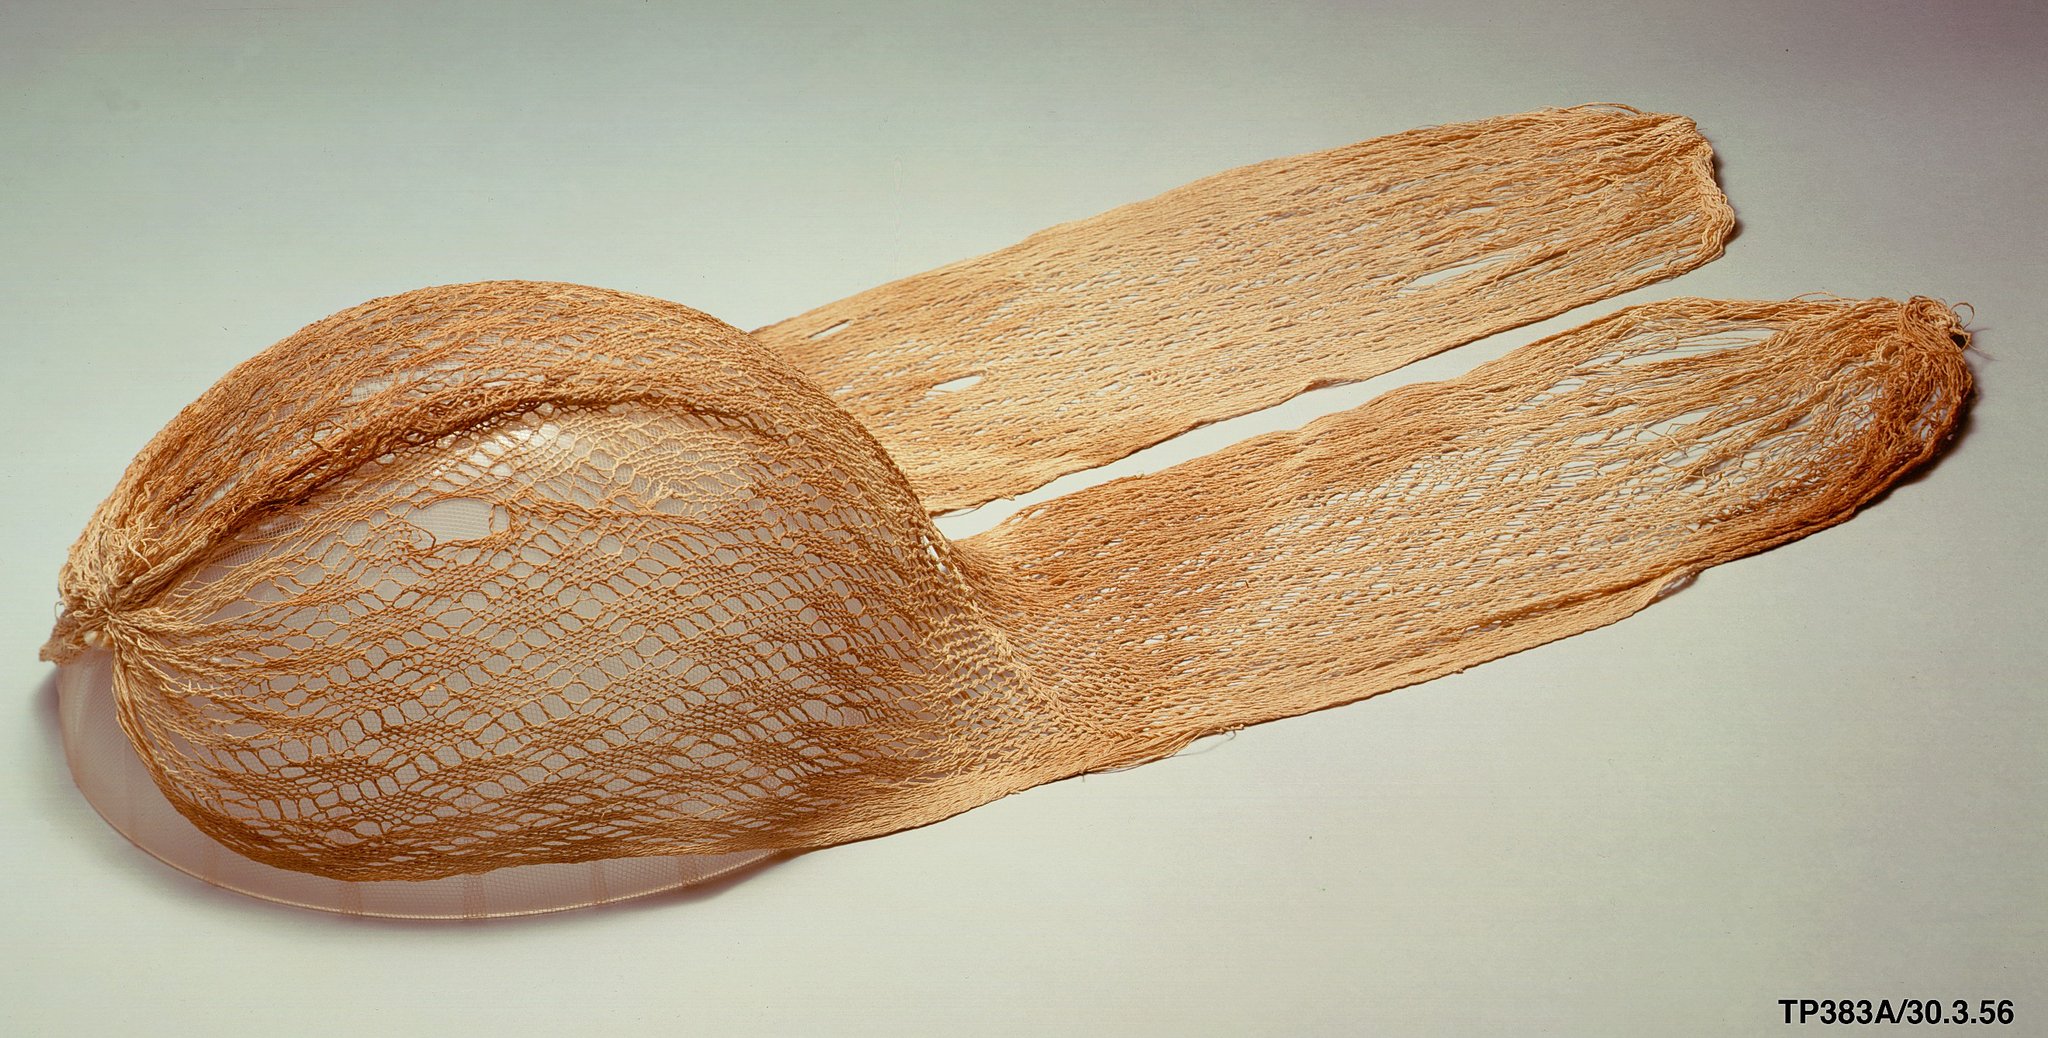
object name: turban, mummy of a child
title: Turban from the Head of a Mummy of a Child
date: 201-333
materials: linen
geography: egypt